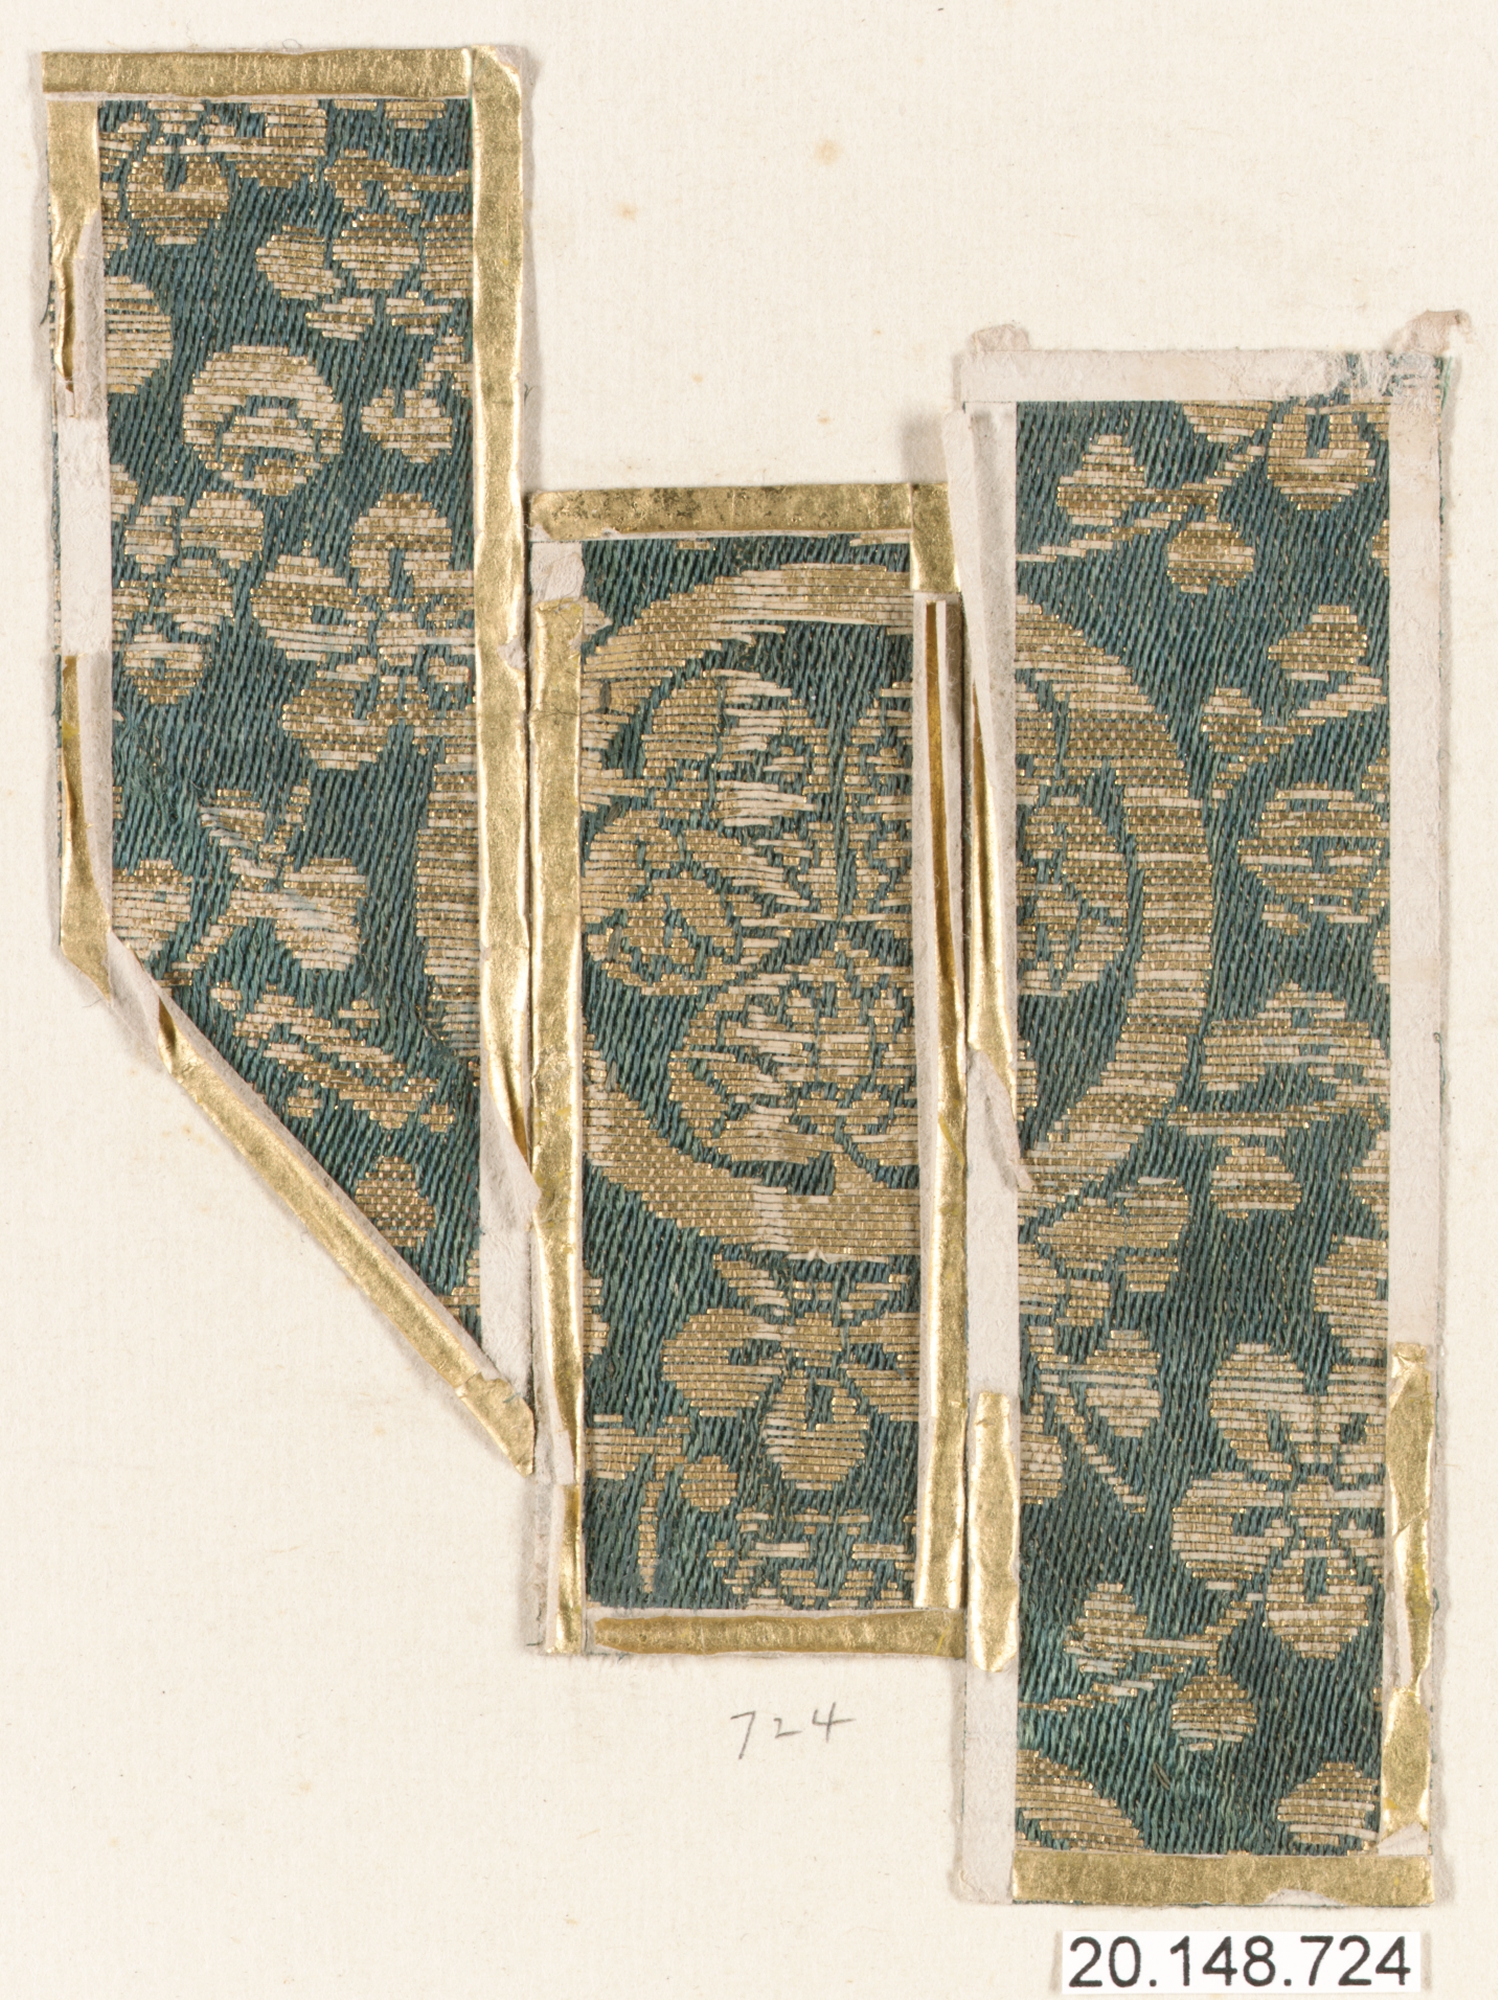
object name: piece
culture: japanese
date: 1601-1700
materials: silk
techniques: compound weave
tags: flowers